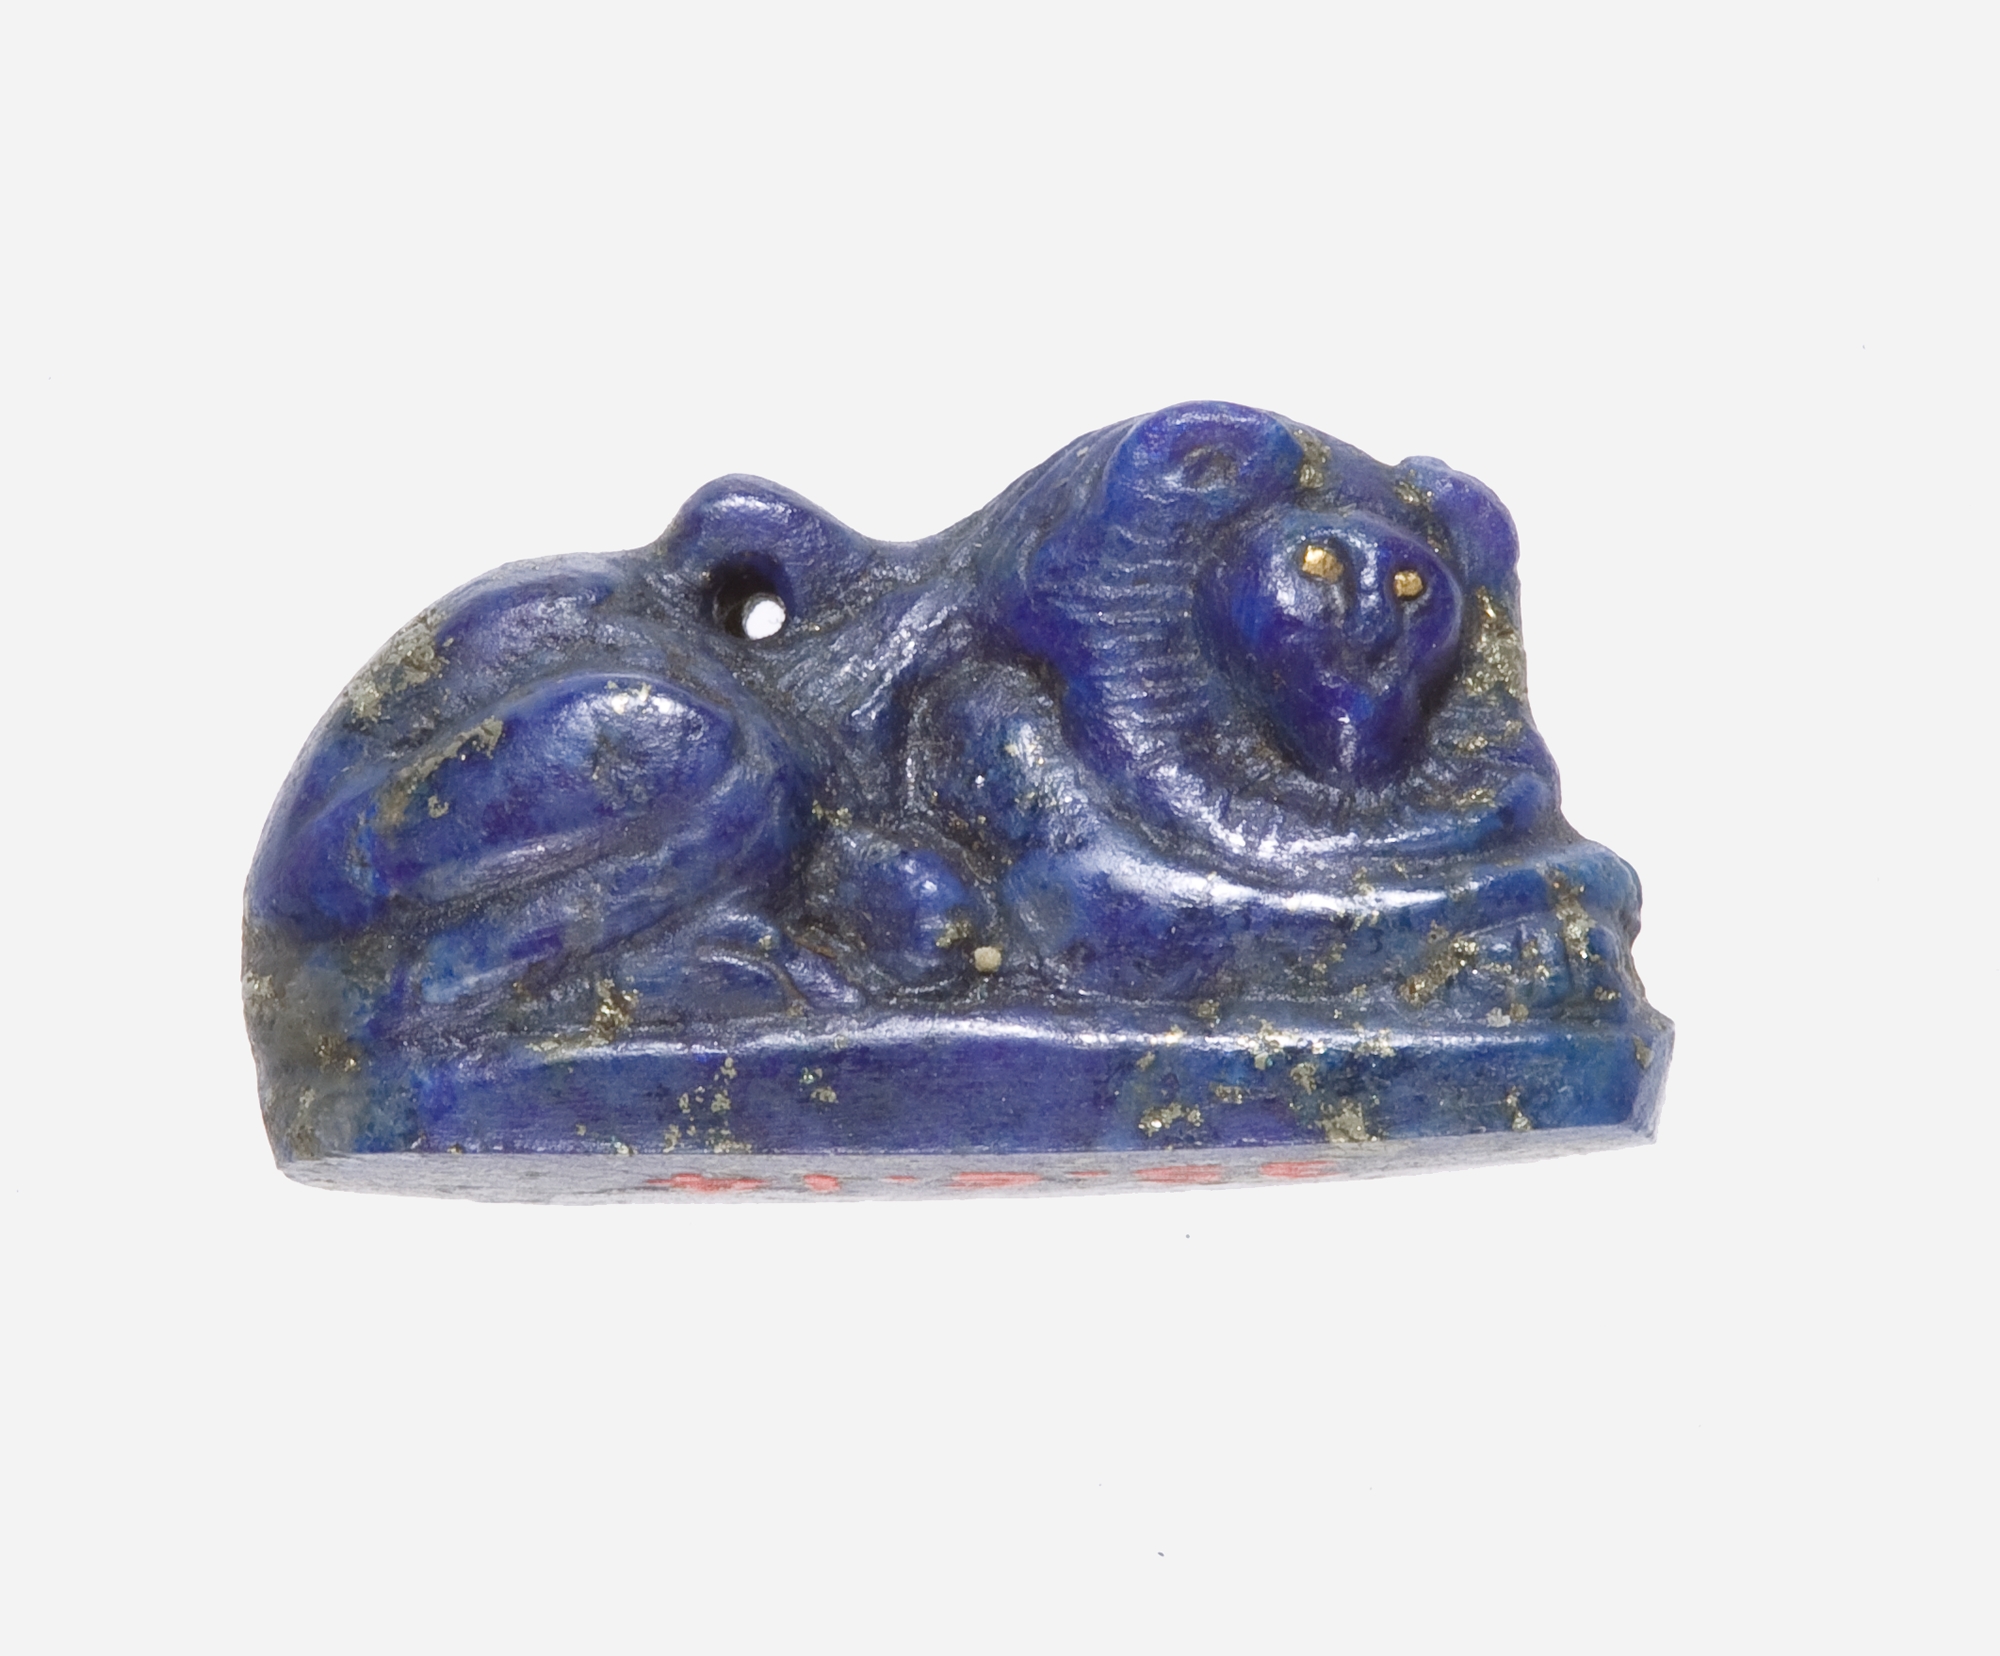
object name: amulet, lion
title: Recumbent lion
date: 664-630 BCE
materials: gold, lapis lazuli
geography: egypt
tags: lions